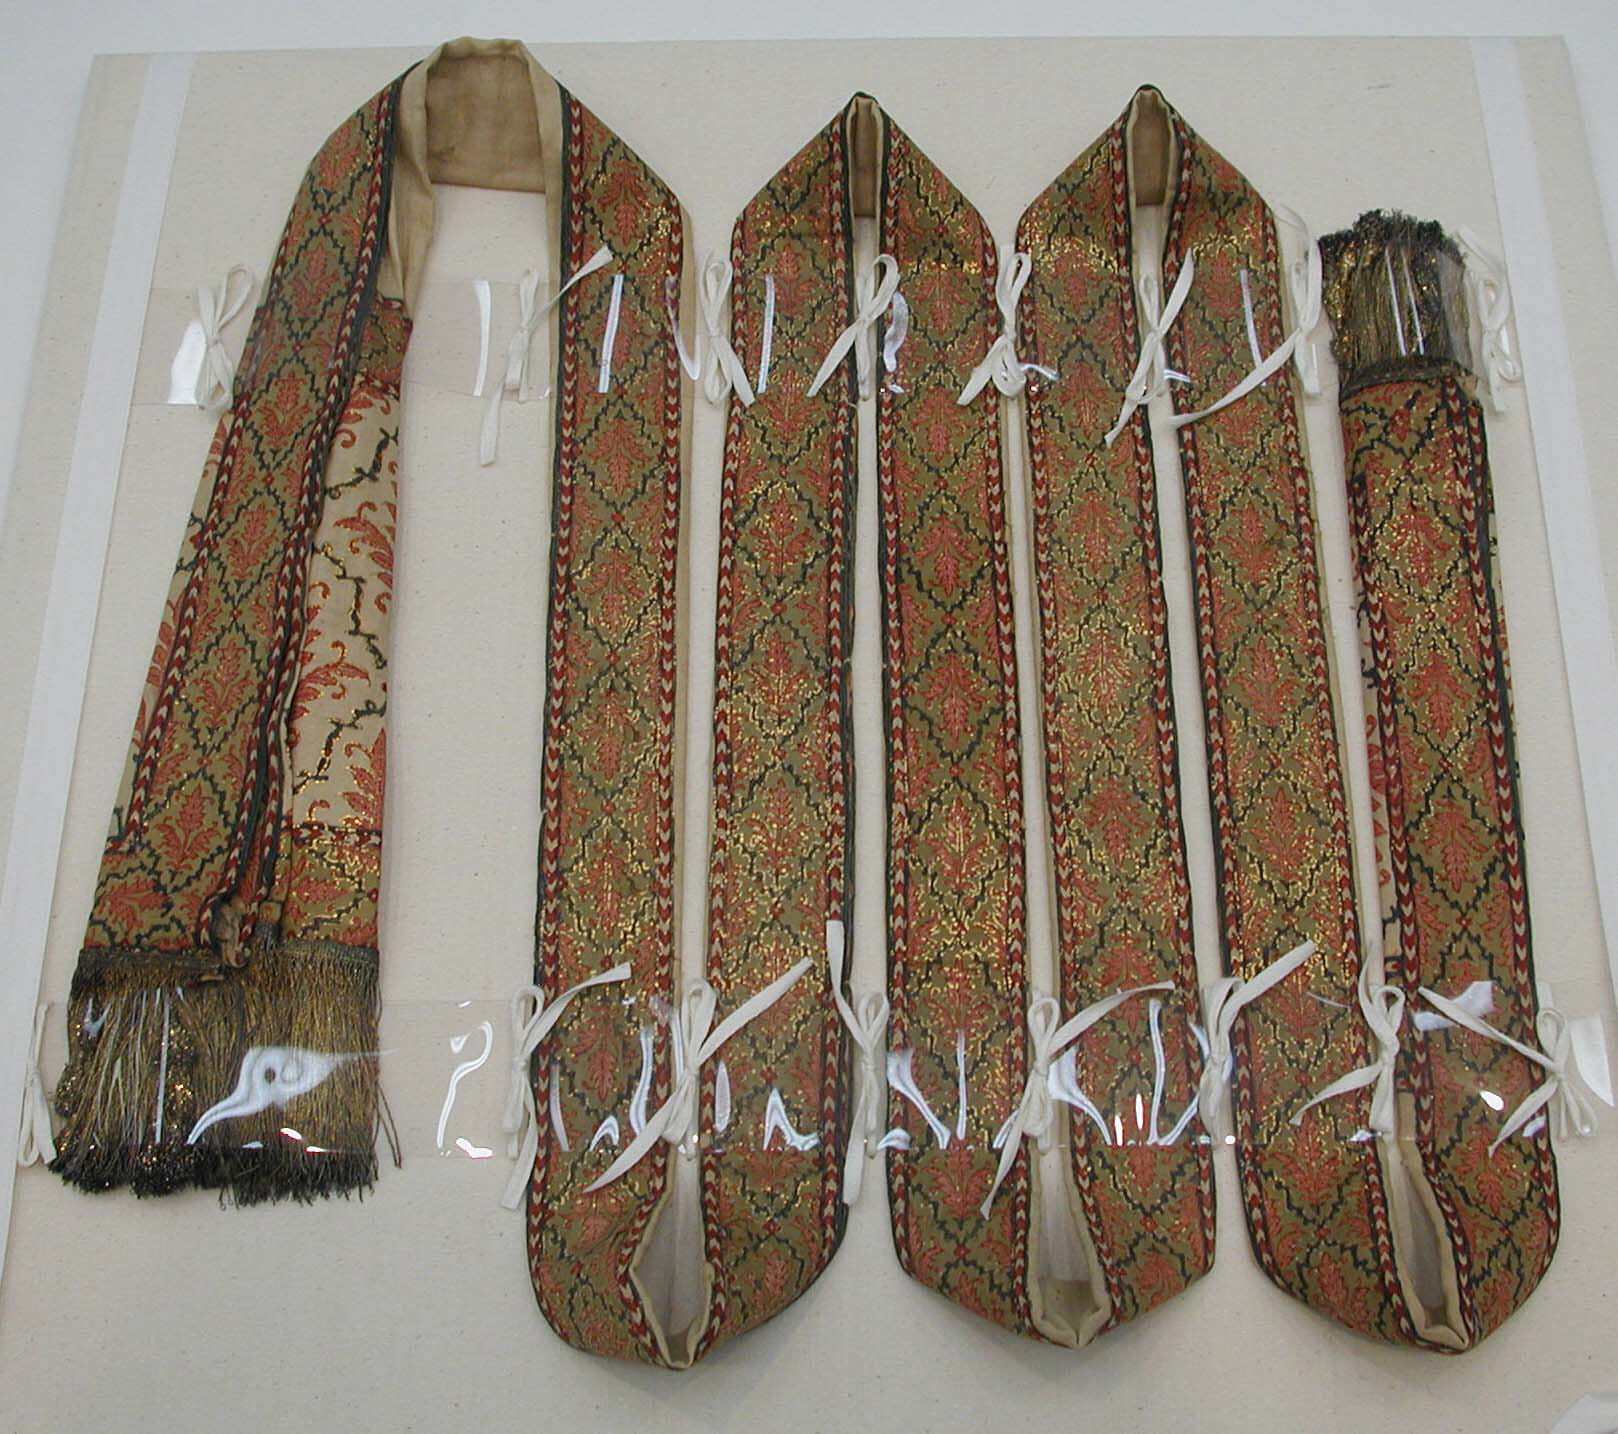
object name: sash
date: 1628-1658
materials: cotton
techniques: dyeing, painting, resist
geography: india